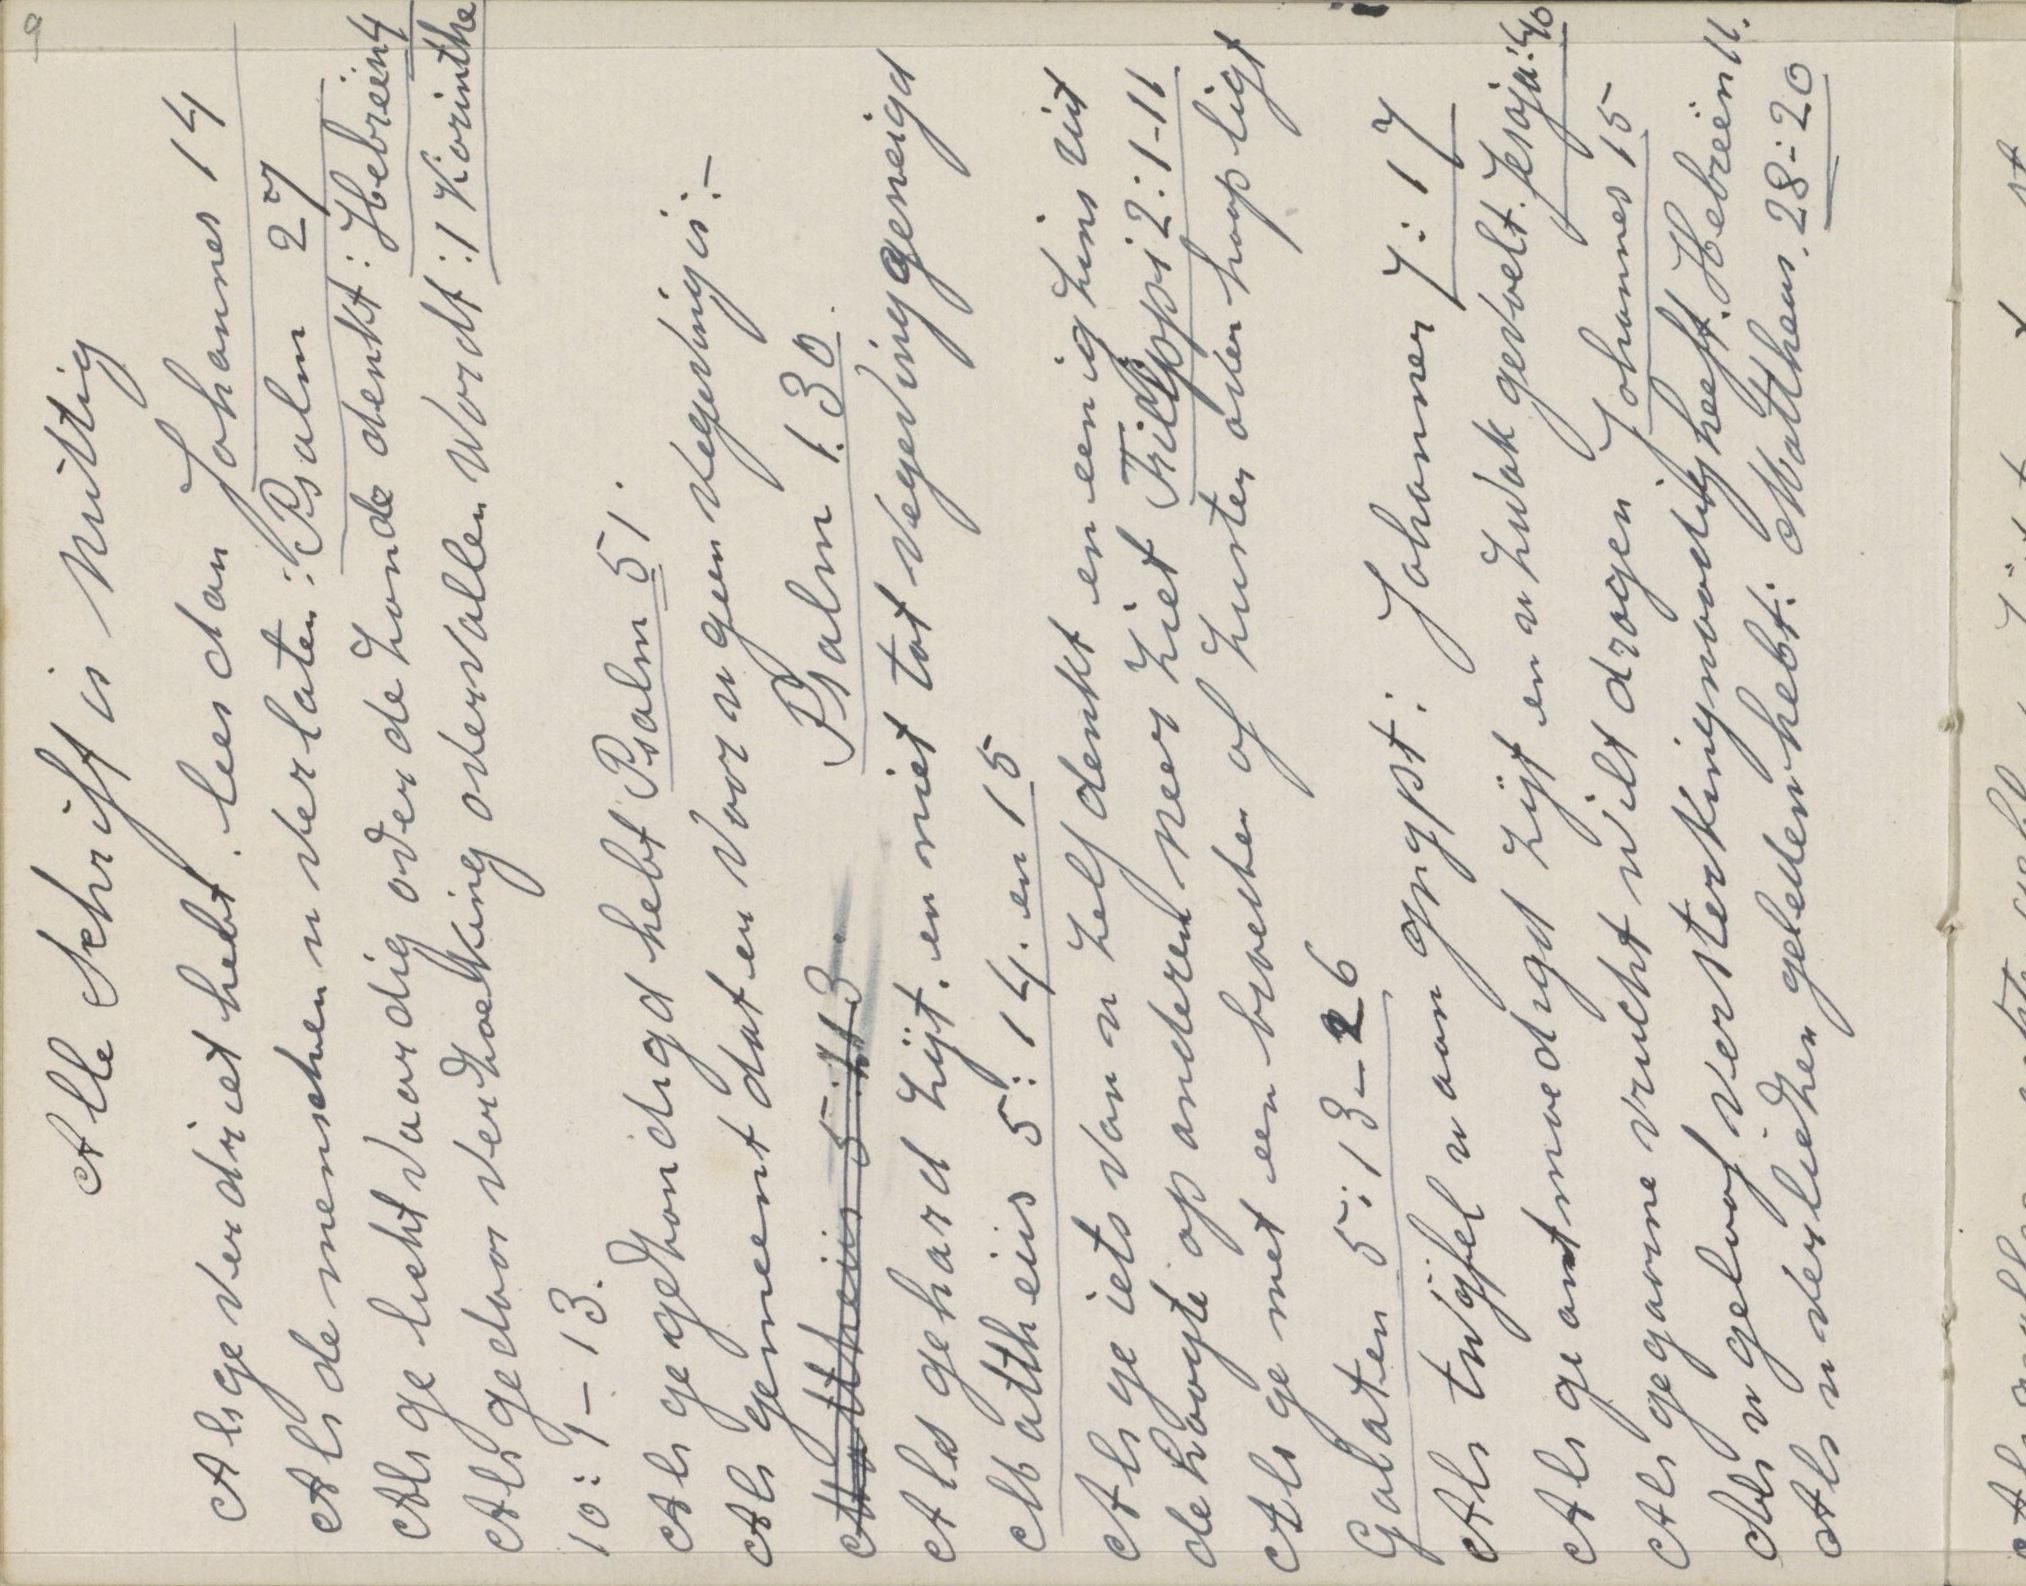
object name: sketchbook leaf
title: Bijbelverzen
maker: marie jordan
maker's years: 1866-1948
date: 1906-1948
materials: ink, paper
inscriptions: annotation: ‘[...]’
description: Pagina 9 uit een schetsboek met 31 bladen.